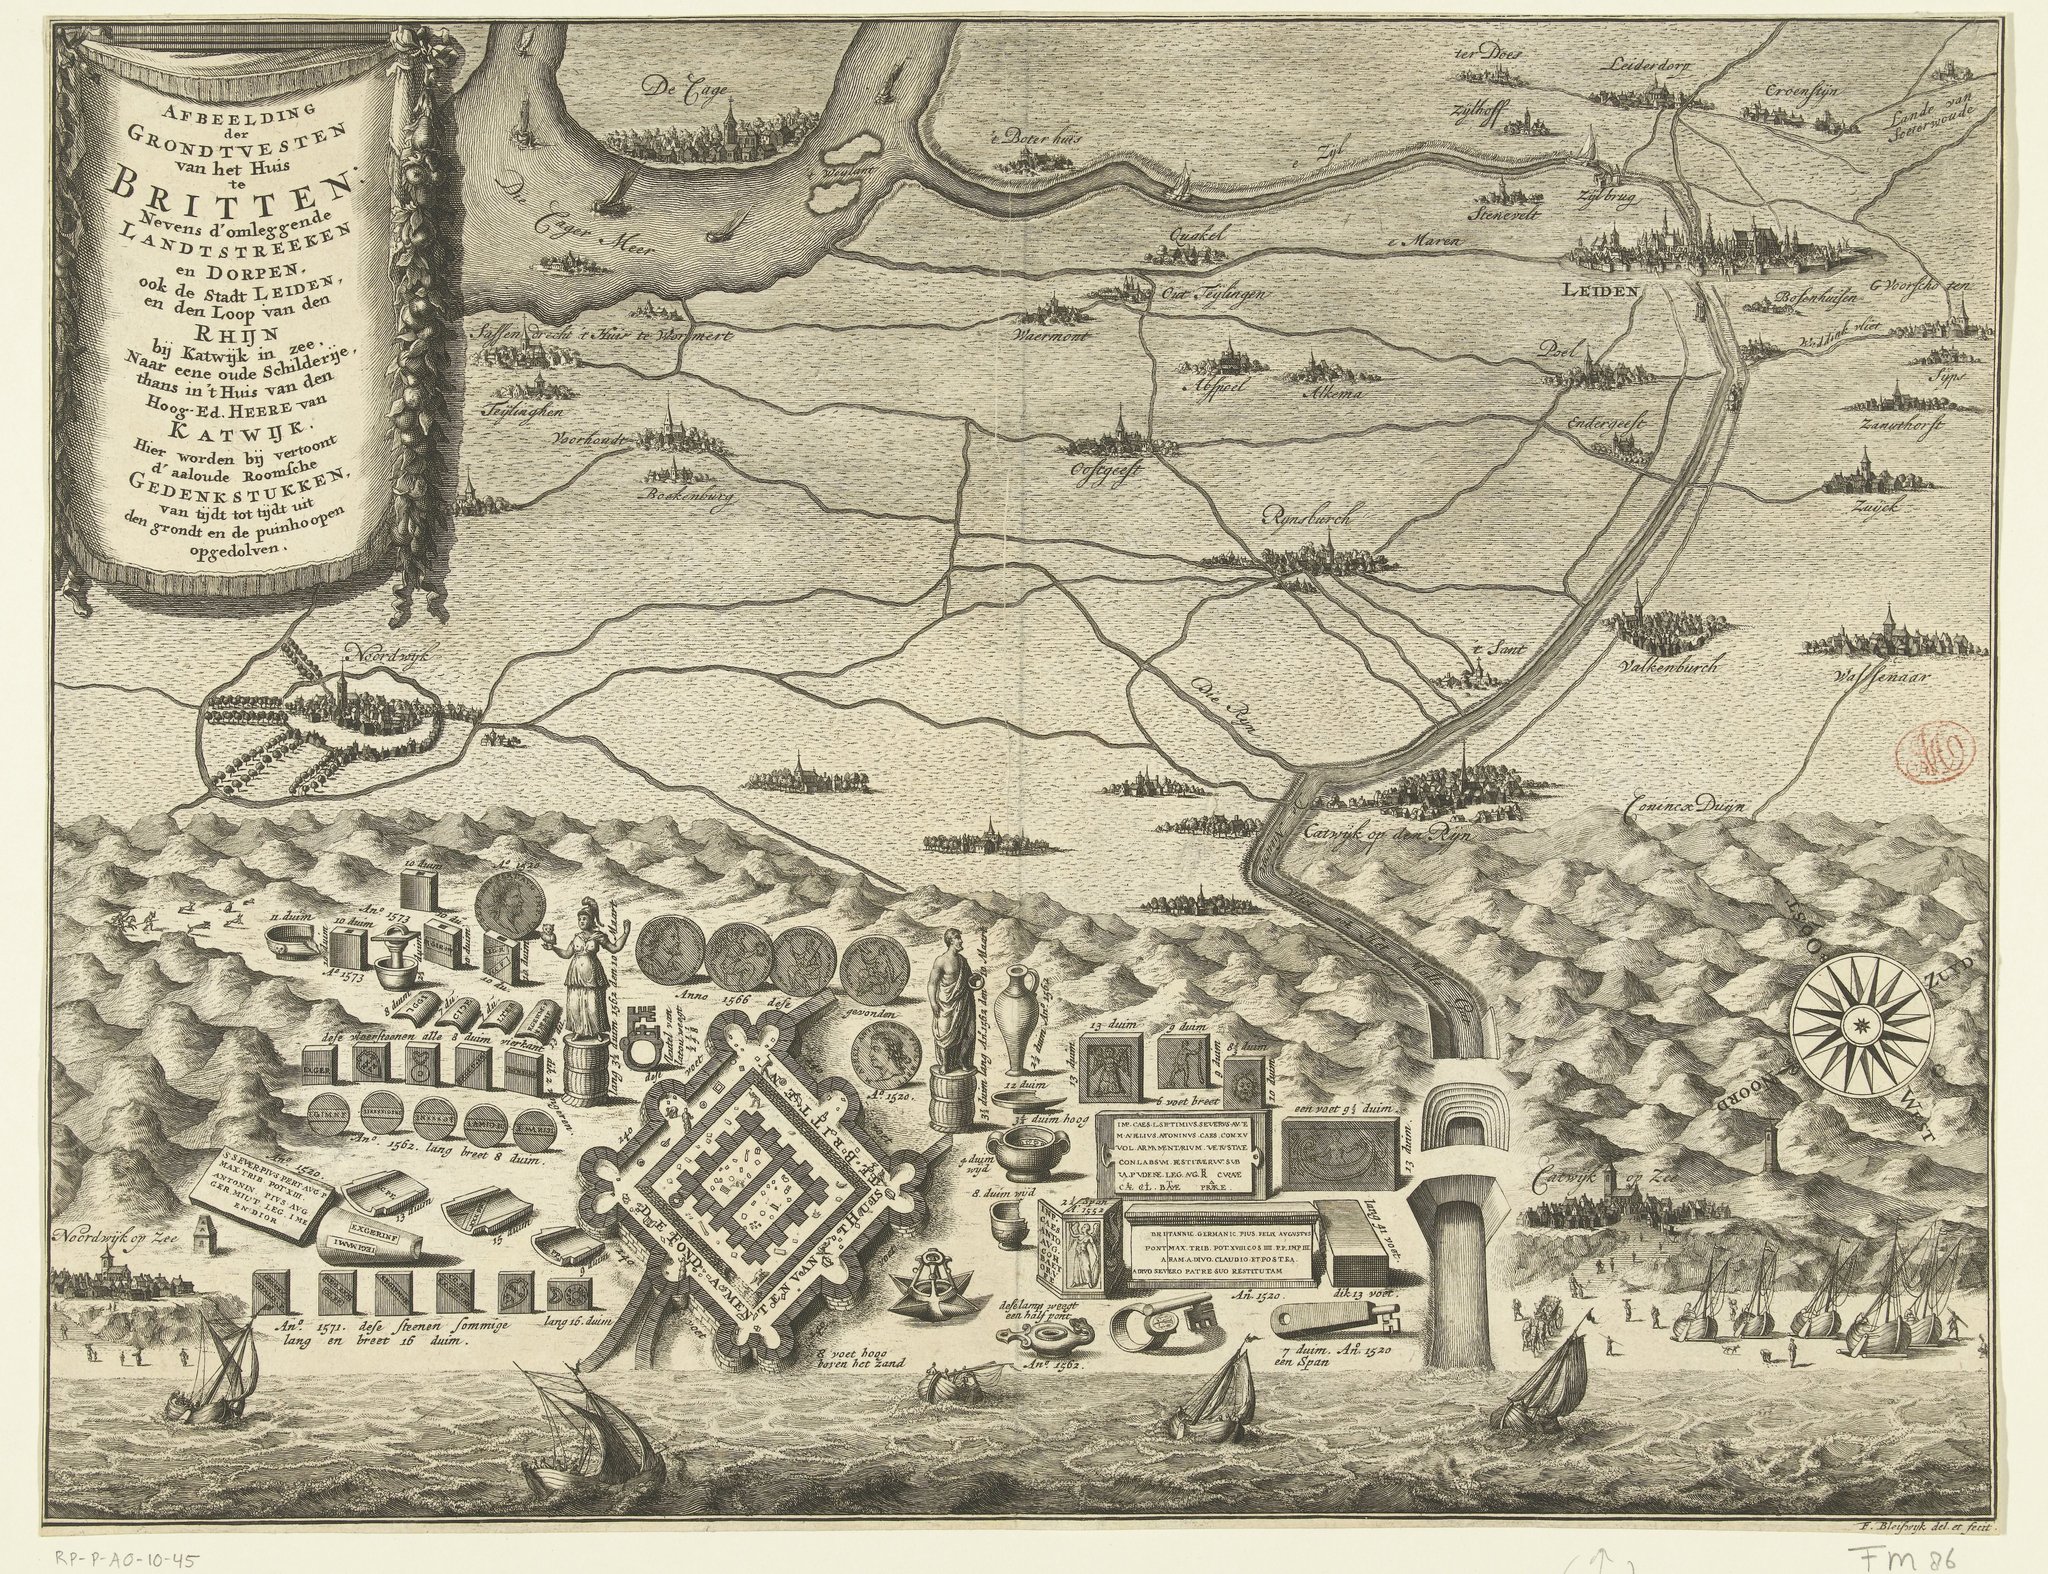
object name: historical object representation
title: Afbeelding der Grondtvesten van het Huis te Britten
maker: françois van bleyswijck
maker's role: draughtsman, print maker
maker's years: 1671-1746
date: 1728-1739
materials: paper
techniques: etching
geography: northern netherlands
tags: maps of separate countries or regions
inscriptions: collector's mark: Lugt 2228, collector's mark: Lugt 195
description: Plattegrond van het Huis te Britten opgenomen in een kaart van de omgeving. Onderaan de kust, daaracher de duinen en het achterland met de daarin gelegen plaatsen Katwijk aan Zee, Leiden, Wassenaar etc. Linksboven een cartouche met de titel.